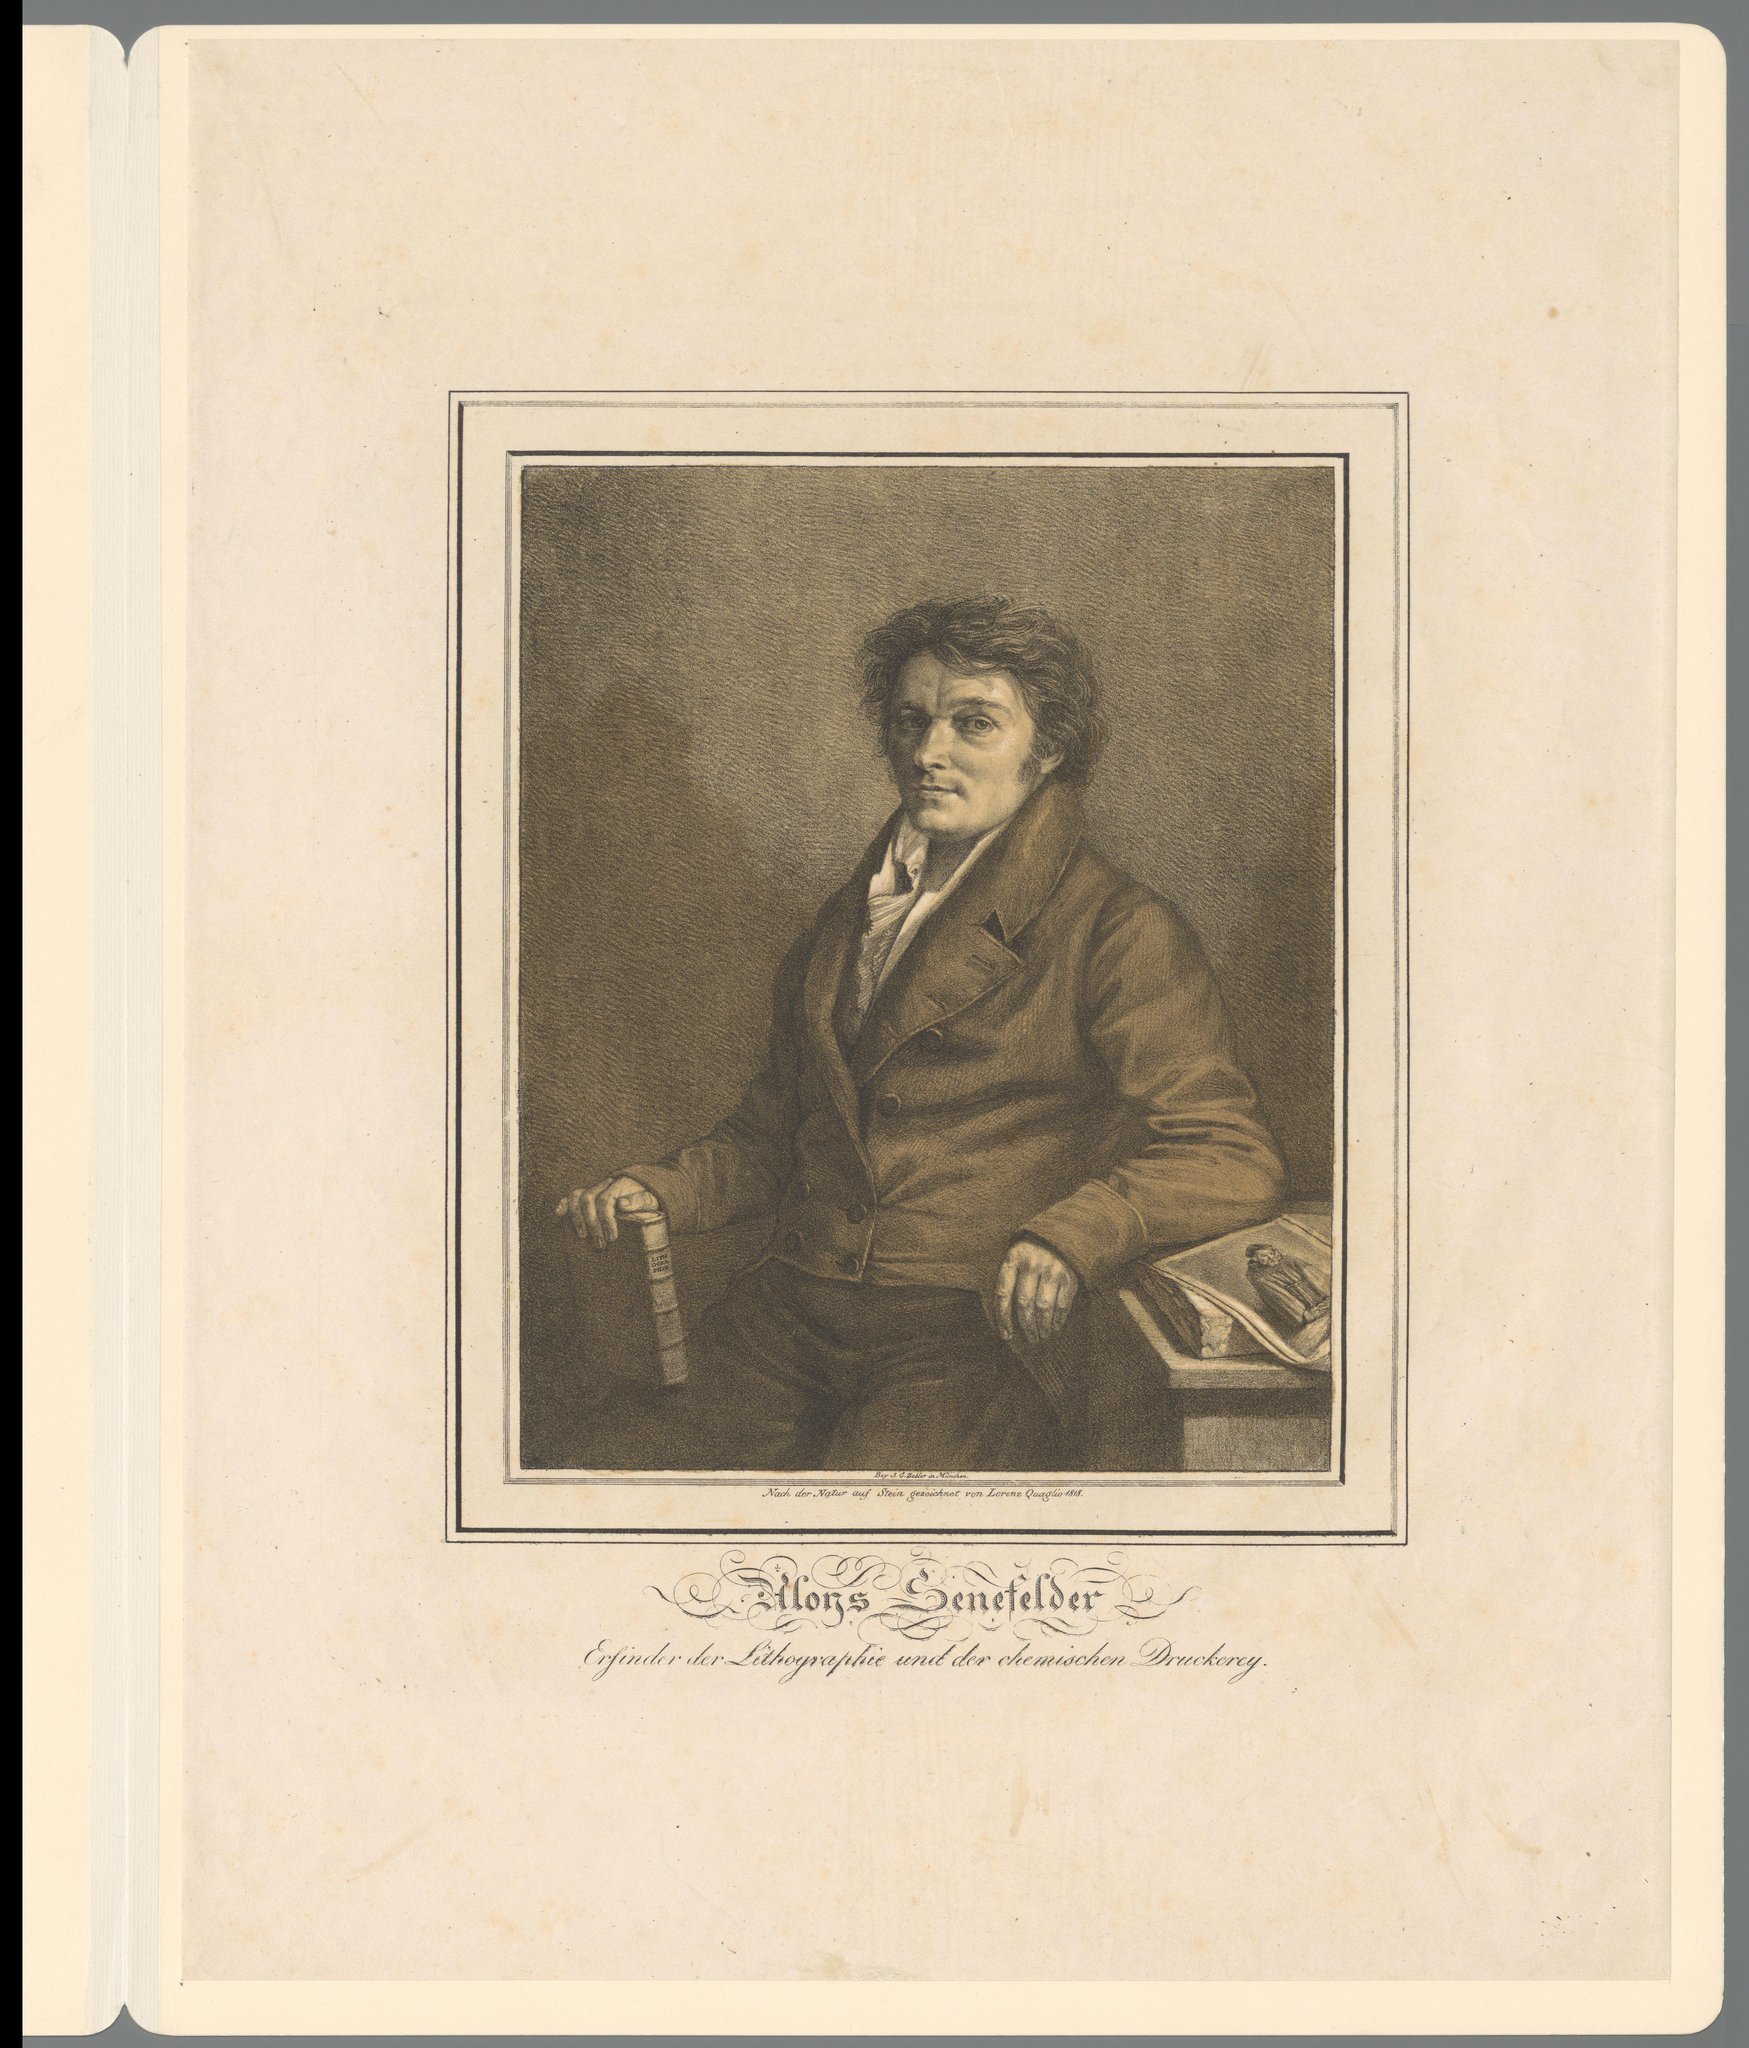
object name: print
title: Portret van Alois Senefelder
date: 1818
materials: paper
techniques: tone lithography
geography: munich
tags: print maker, printer, alois senefelder, print, e.g.: engraving, etching, lithograph, historical persons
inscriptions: collector's mark: Lugt 805b